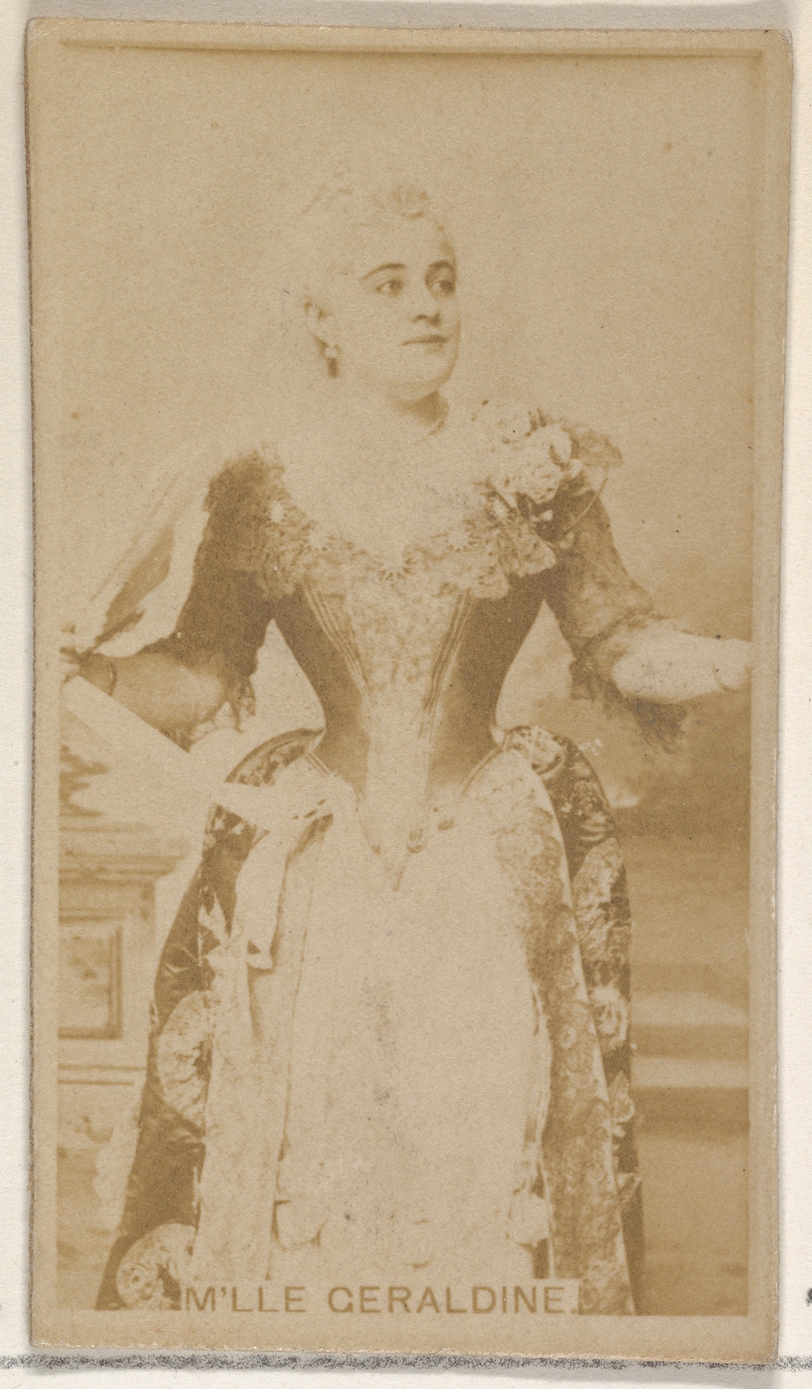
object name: photograph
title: M'lle Geraldine, from the Actors and Actresses series (N45, Type 8) for Virginia Brights Cigarettes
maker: allen & ginter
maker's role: publisher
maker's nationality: american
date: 1888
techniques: albumen silver print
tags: portraits,women,actresses